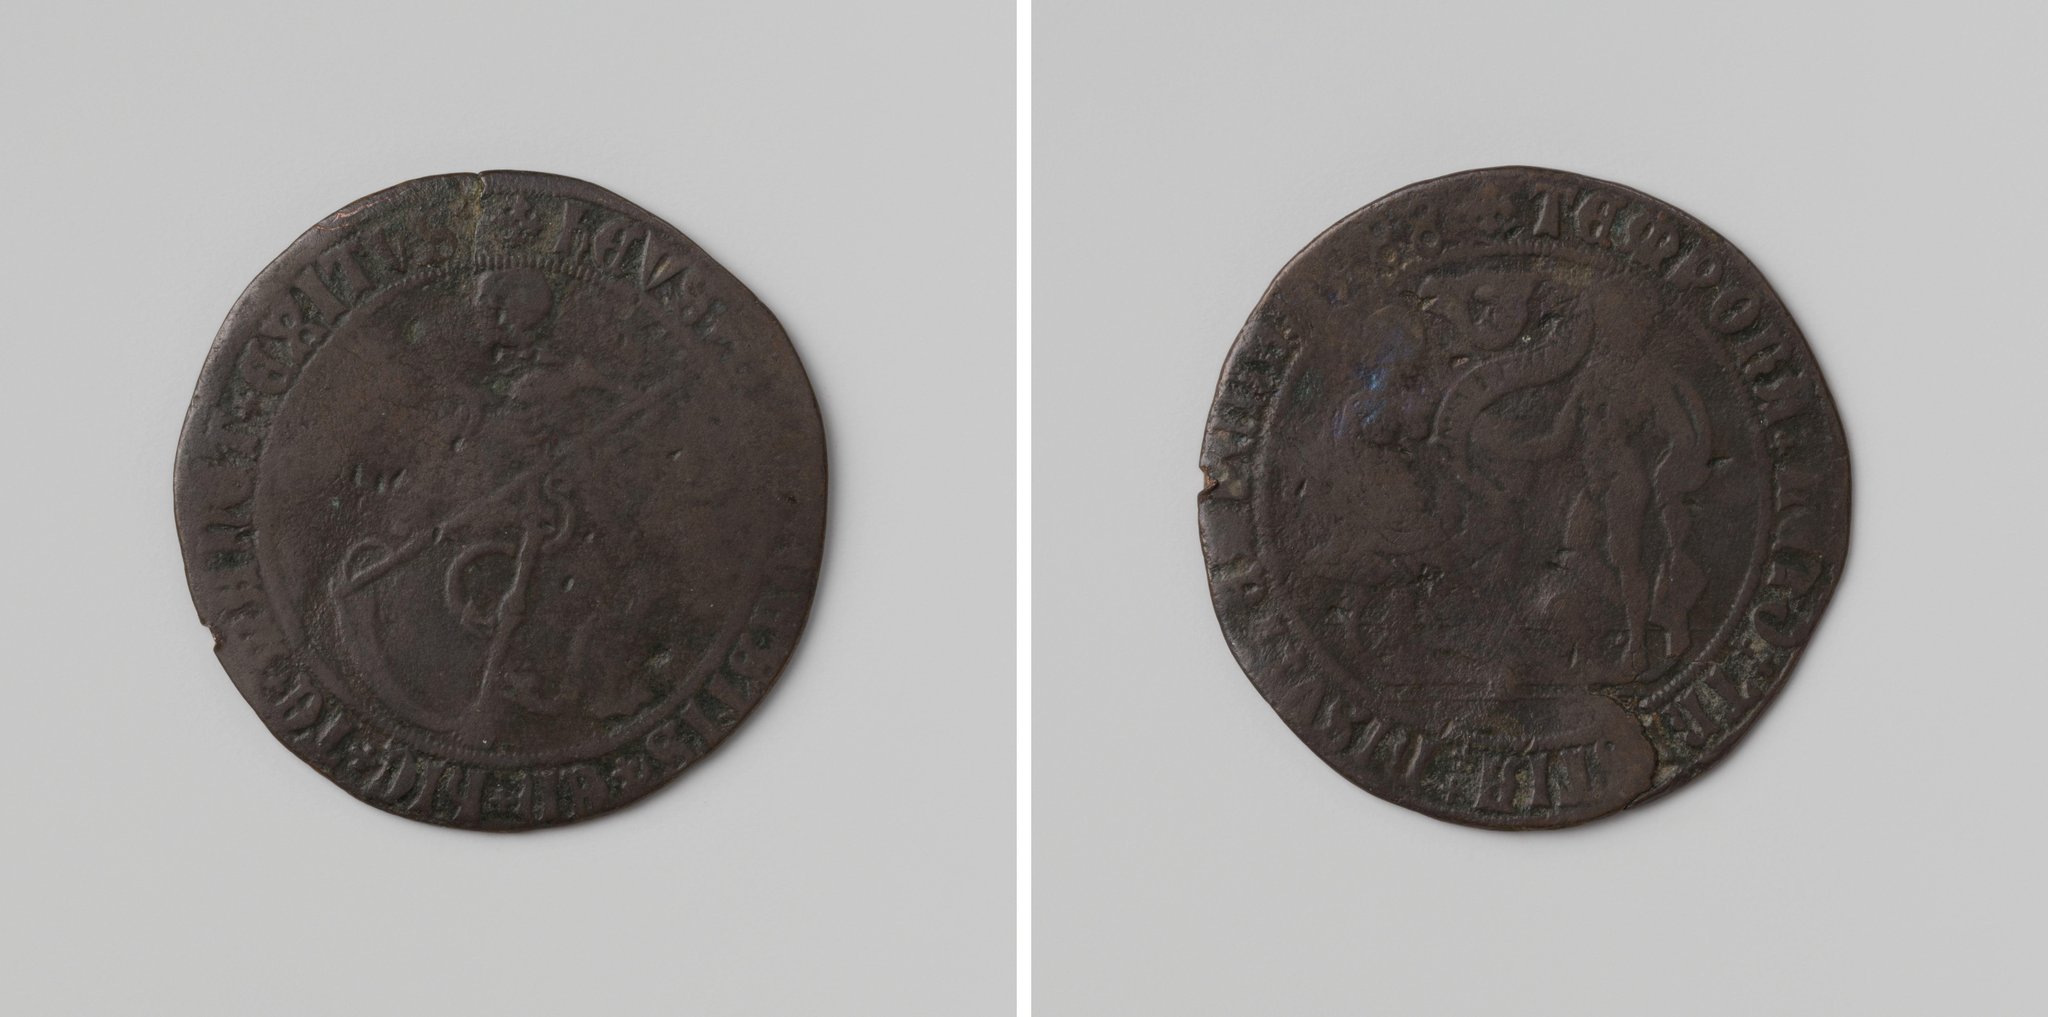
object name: jeton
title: Allegorie op het slechte bewind van Maximiliaan, aartshertog van Oostenrijk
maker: Anonymous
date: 1488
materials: copper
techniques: striking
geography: netherlands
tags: maximilian i (holy roman emperor)